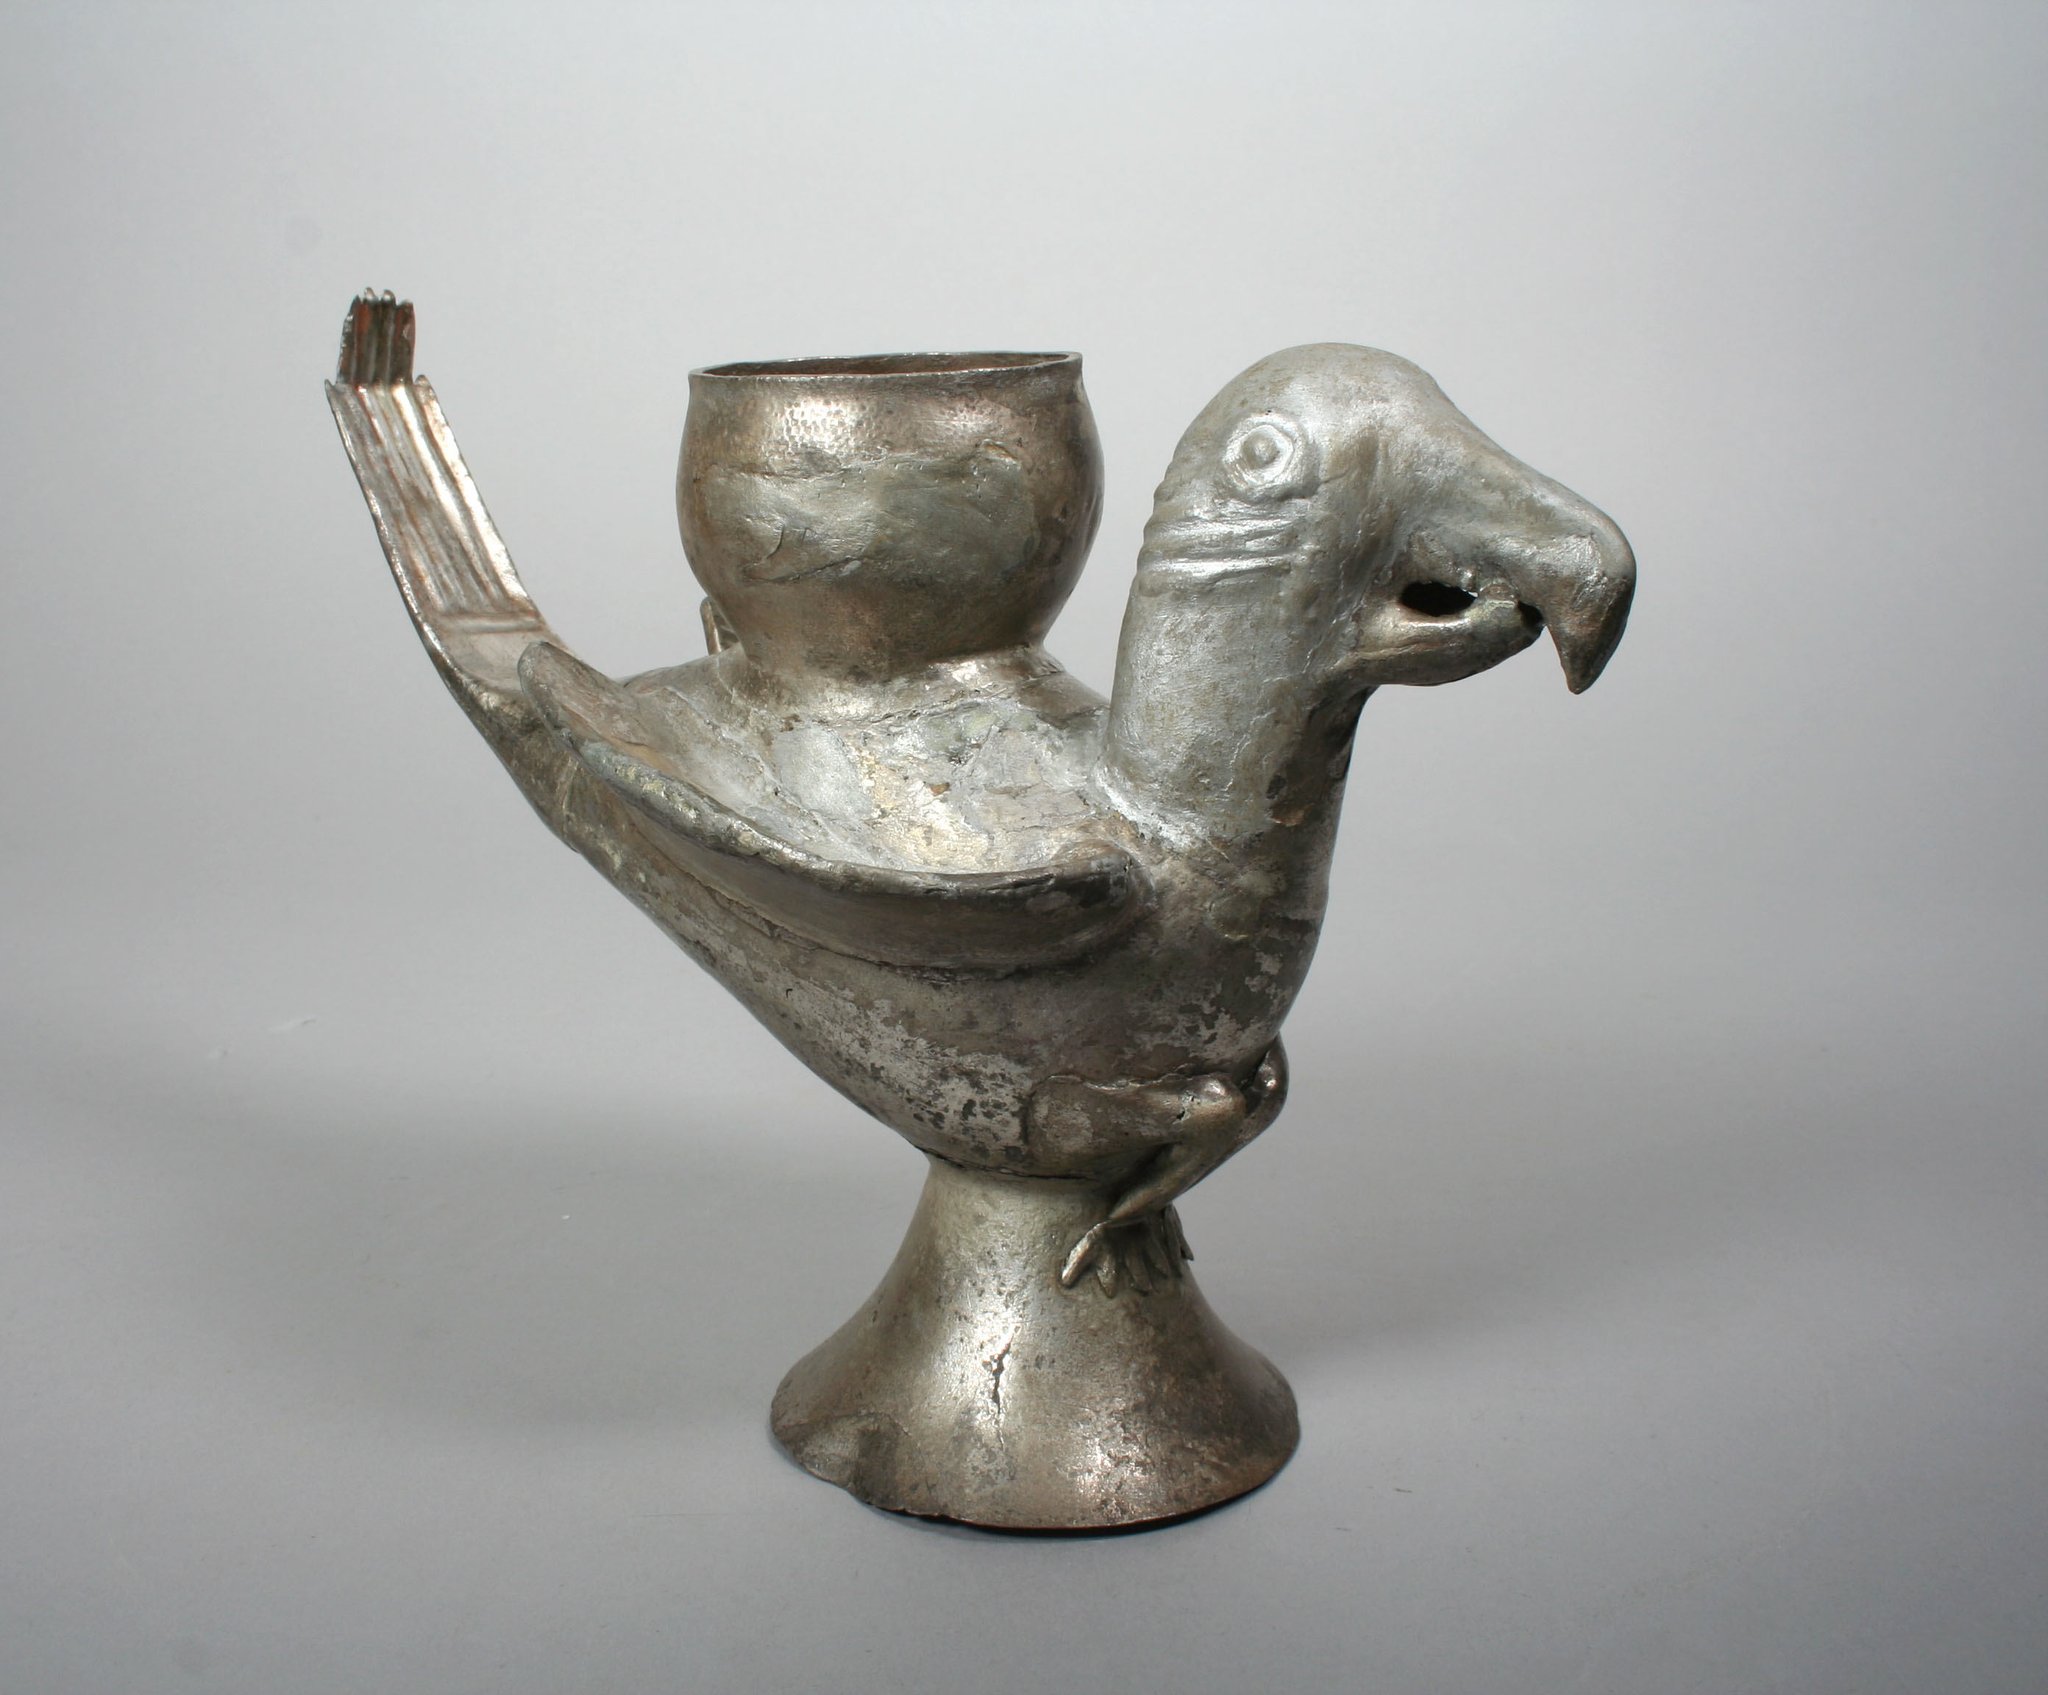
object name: vessel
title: Bird-shaped vessel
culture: chimú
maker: chimú artist(s)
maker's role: artist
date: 1100-1470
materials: silver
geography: peru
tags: birds